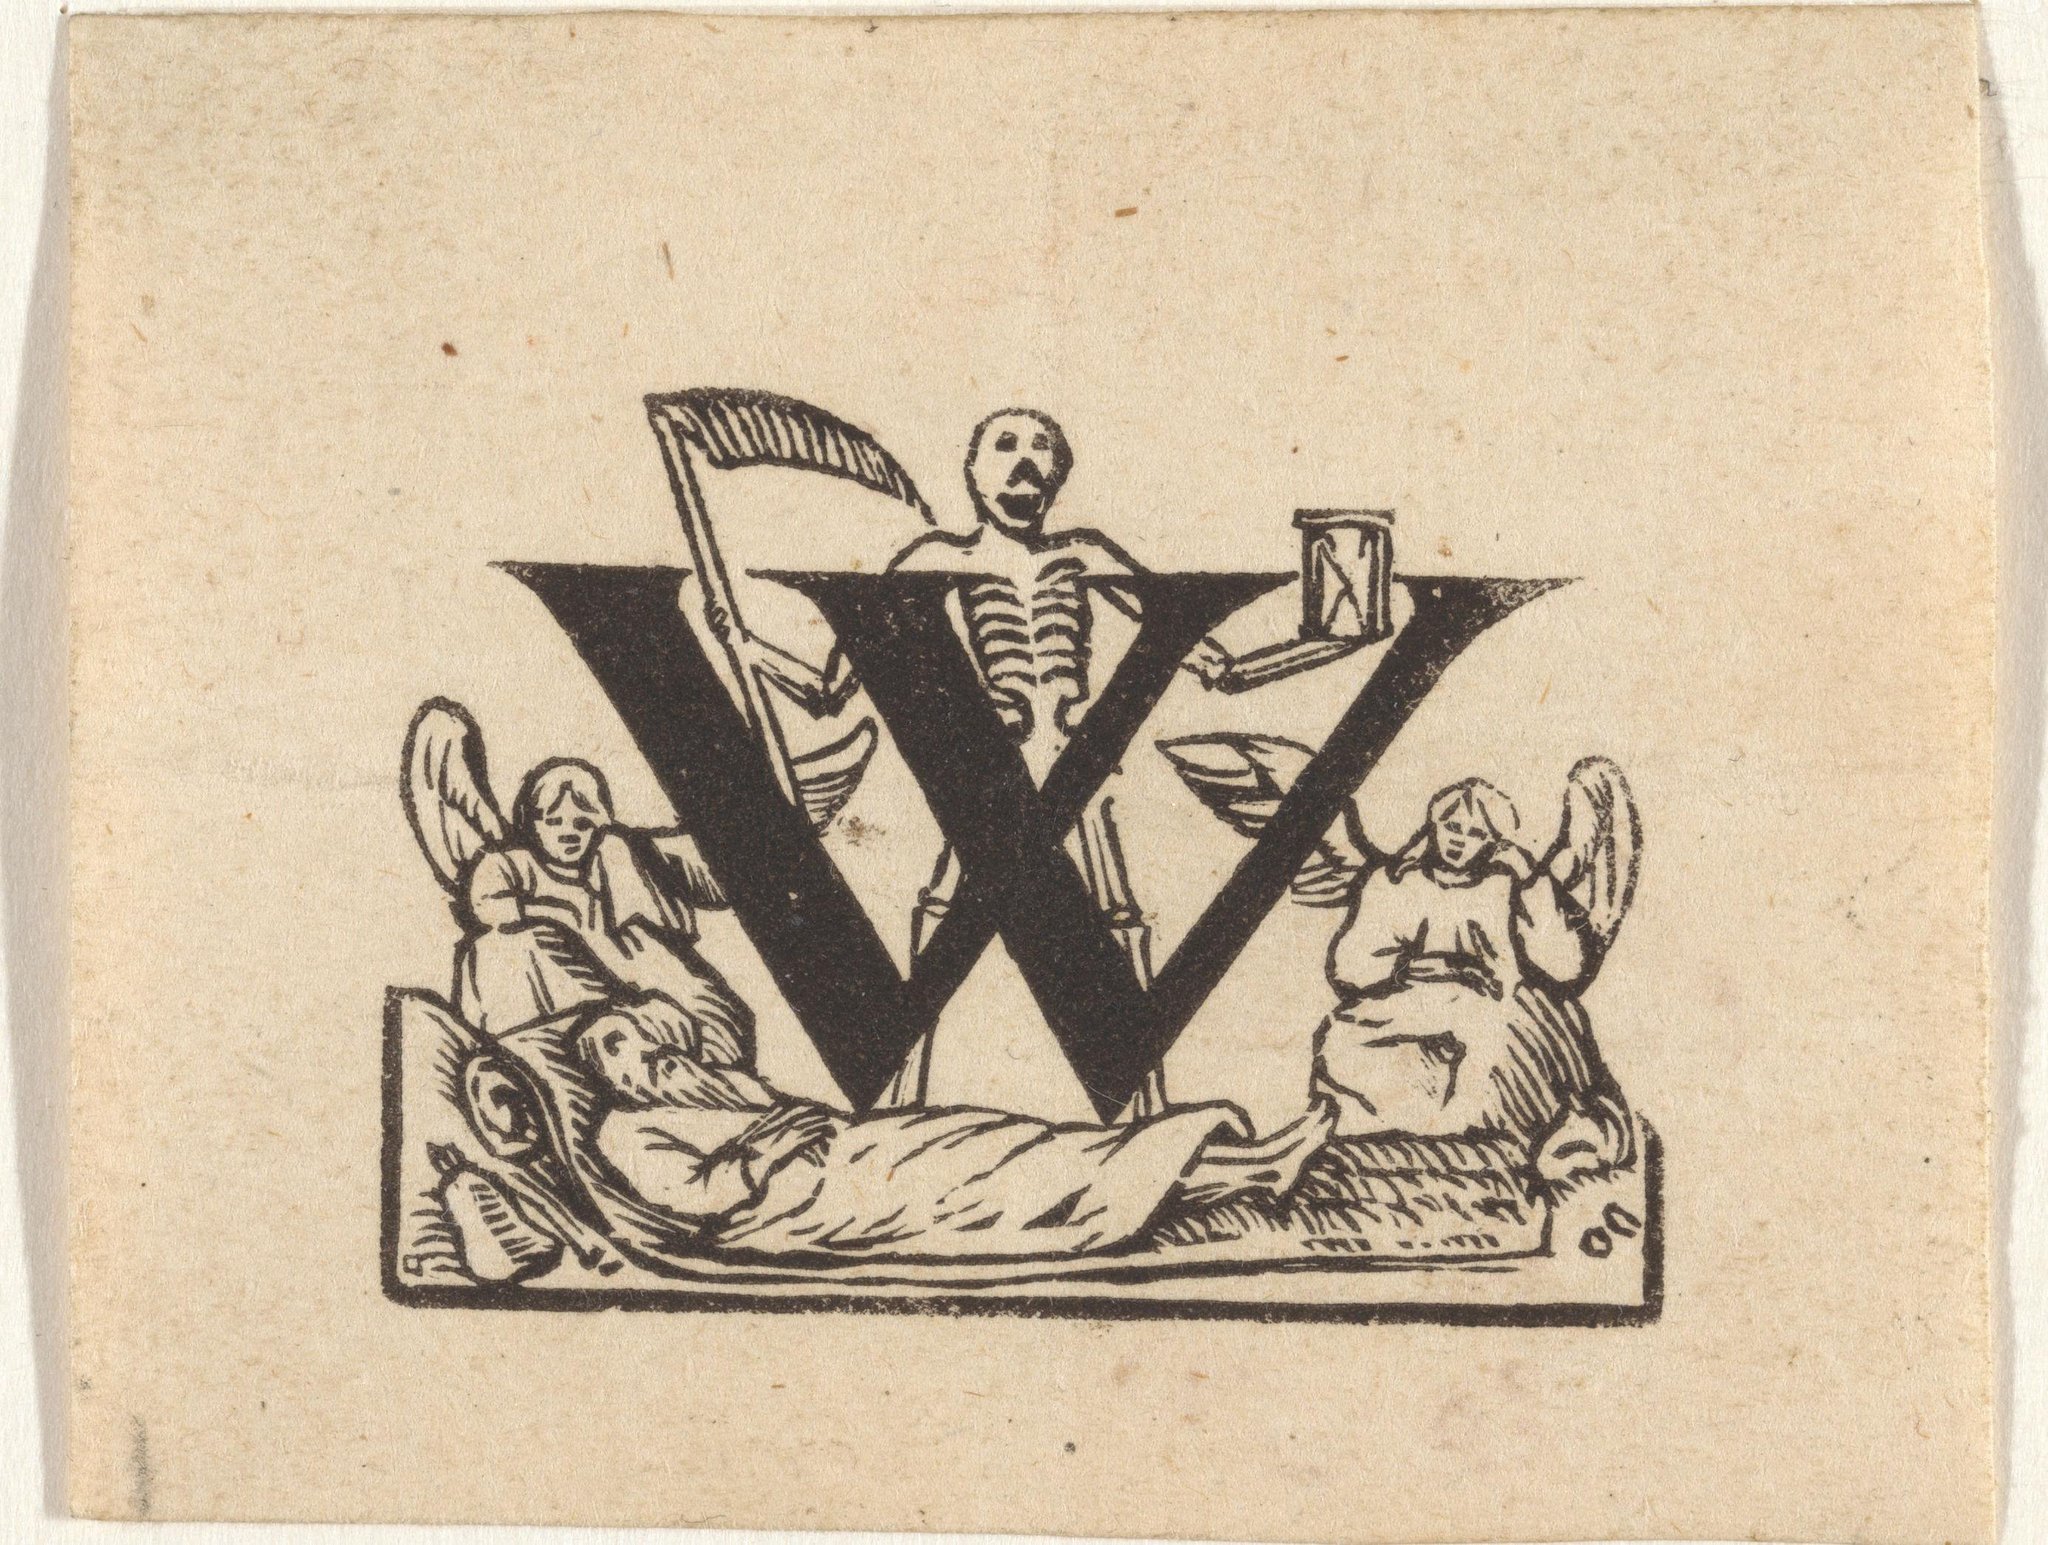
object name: print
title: Letter W met de Dood en twee treurende engelen bij een opgebaard lichaam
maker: Anonymous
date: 1600-1699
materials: paper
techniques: woodcut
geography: netherlands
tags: death as skeleton (+ death with scythe), hourglass, fancy letters, the corpse, angels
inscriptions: collector's mark: Lugt 240